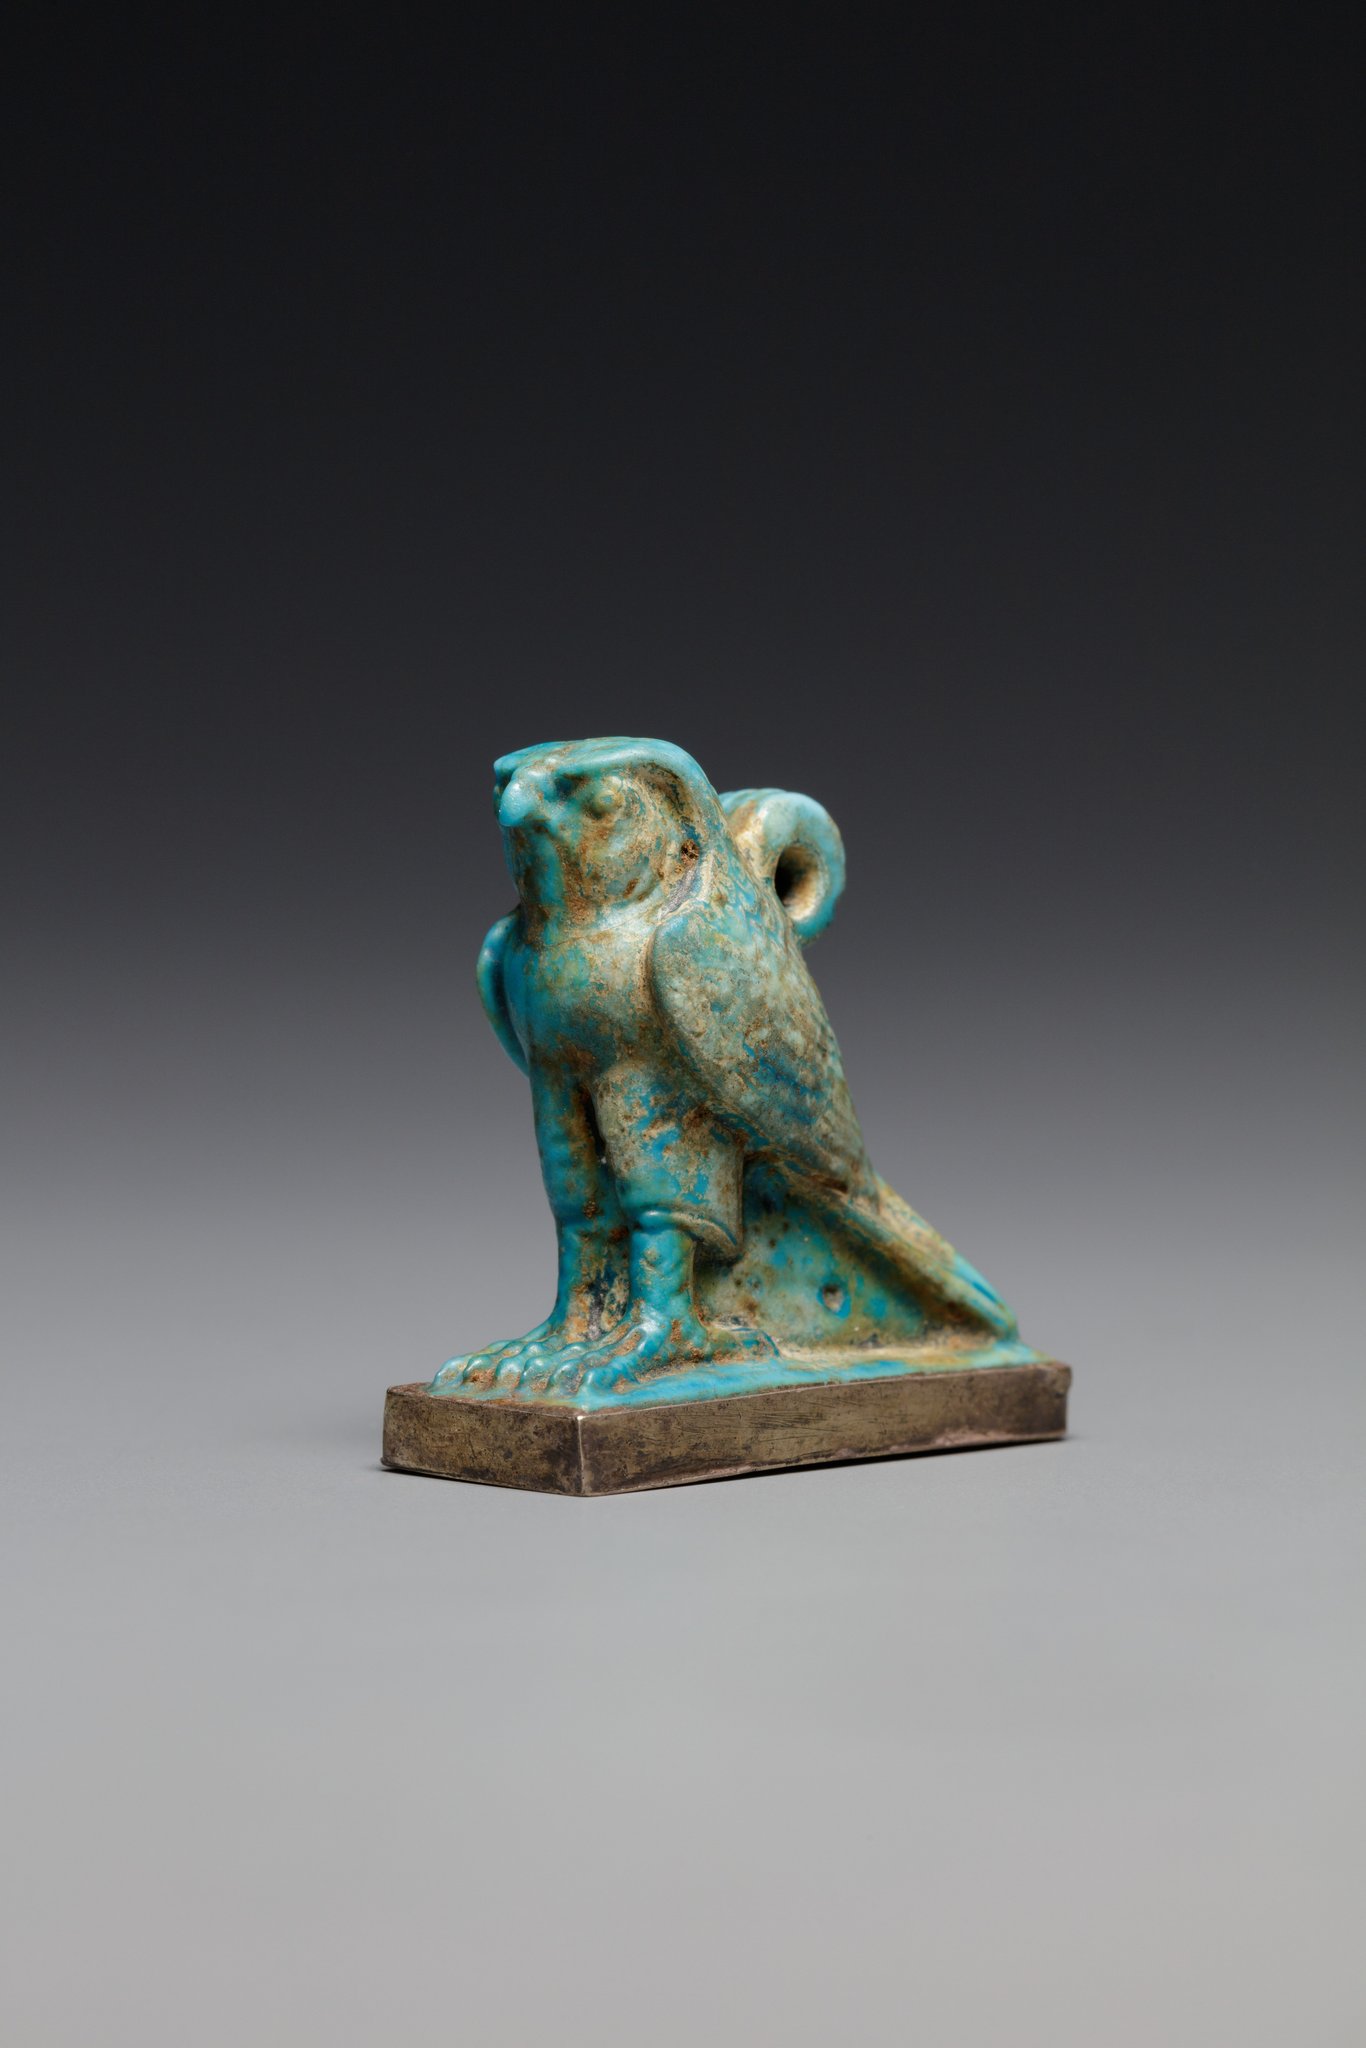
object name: amulet, falcon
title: Falcon Amulet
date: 664-332 BCE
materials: faience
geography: egypt